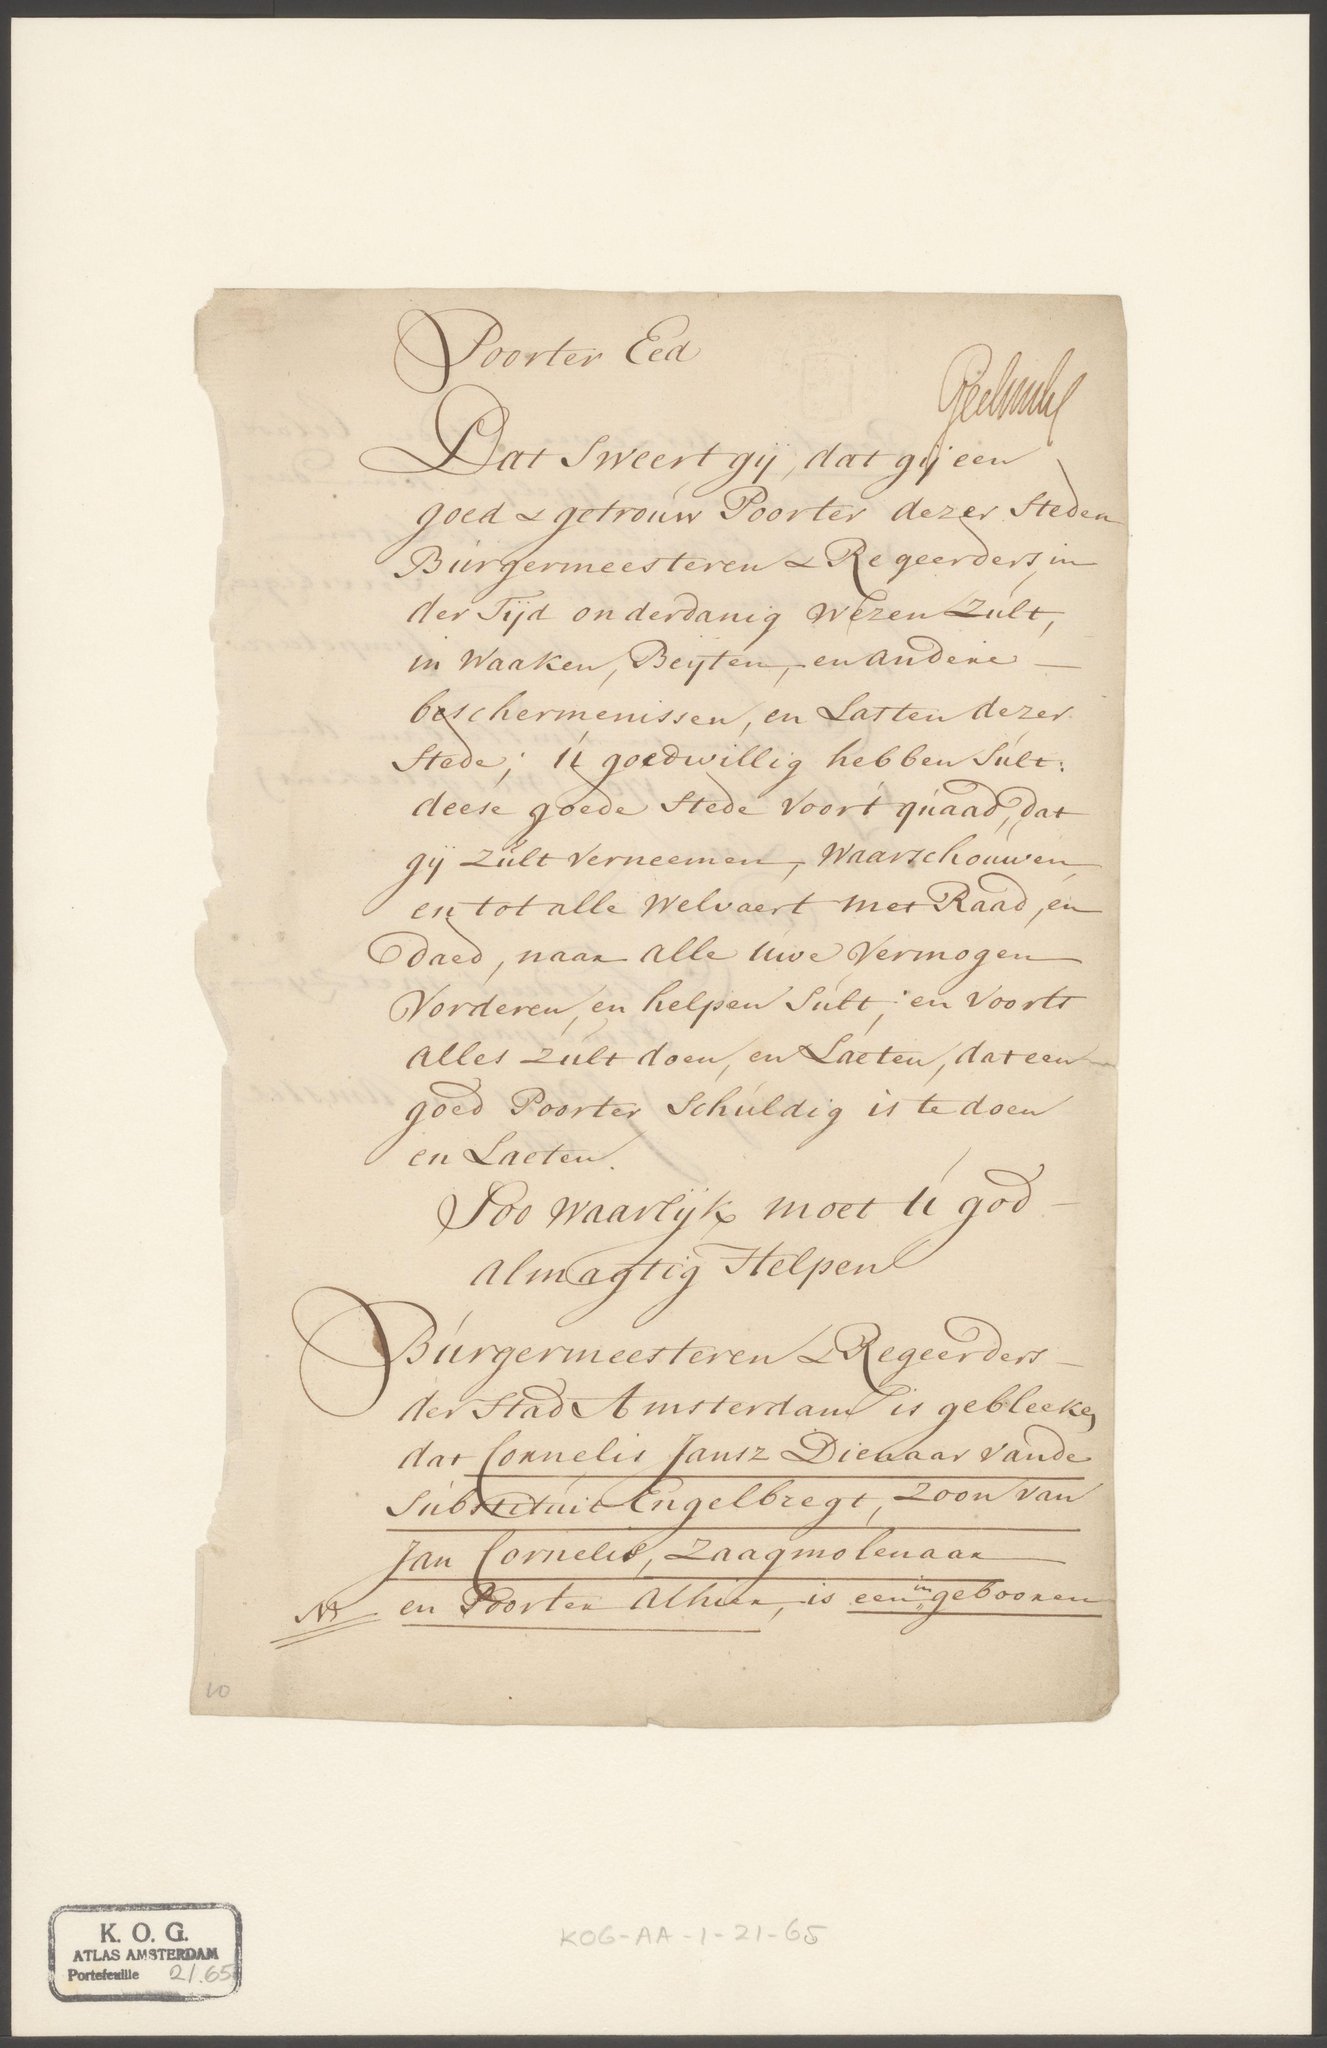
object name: document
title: Poorter Eed van Cornelis Jansz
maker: pieter van loon (1667-1716)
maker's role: bewindhebber, secretaris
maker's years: 1667-1716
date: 1703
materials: ink, paper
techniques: pen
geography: amsterdam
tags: coat of arms (as symbol of the state, etc.) (+ city; municipal), bourgeoisie, middle class, citizens, burghers, amsterdam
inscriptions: signature: ‘Geelvinck’, check stamp, signature: ‘Accordeert met zijn Principaal/ (was getr) J. Ploos van Amstel/ Nots.’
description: Onderwerpsrubriek binnen de Atlas Amsterdam: Poorterbriefjes.